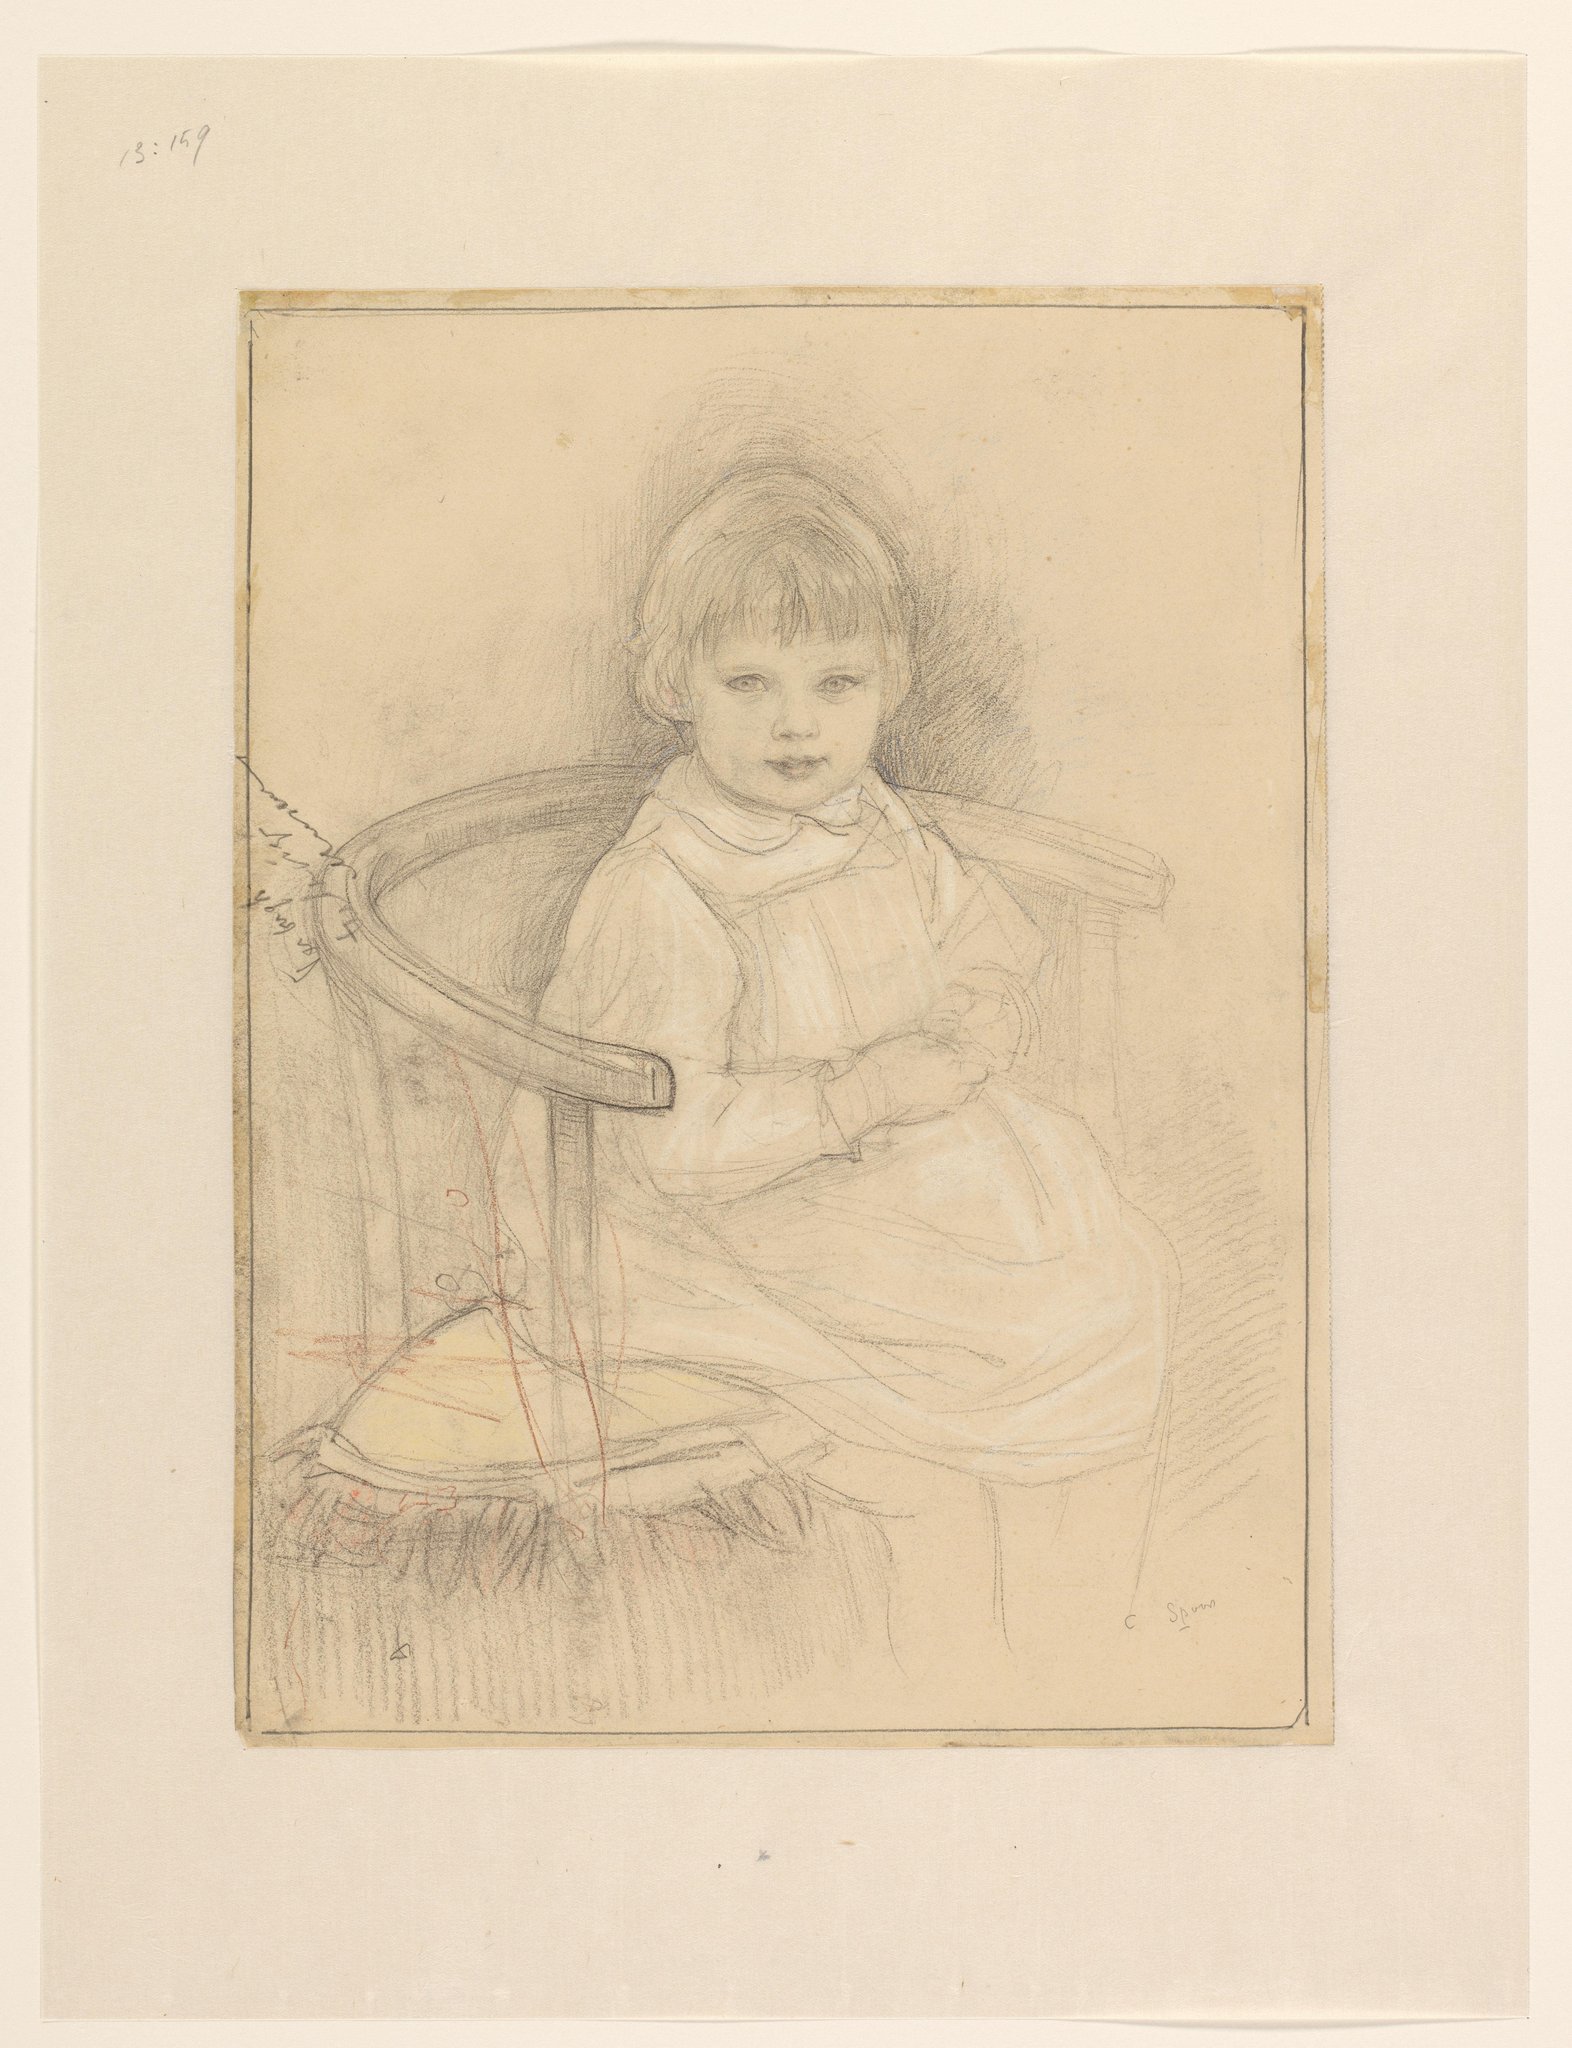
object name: drawing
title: Portret van een meisje zittend op een stoel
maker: cornelis spoor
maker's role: draughtsman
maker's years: 1867-1928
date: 1877-1913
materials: chalk, paper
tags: sitting figure, anonymous historical person portrayed alone, girl (child between toddler and youth), chair